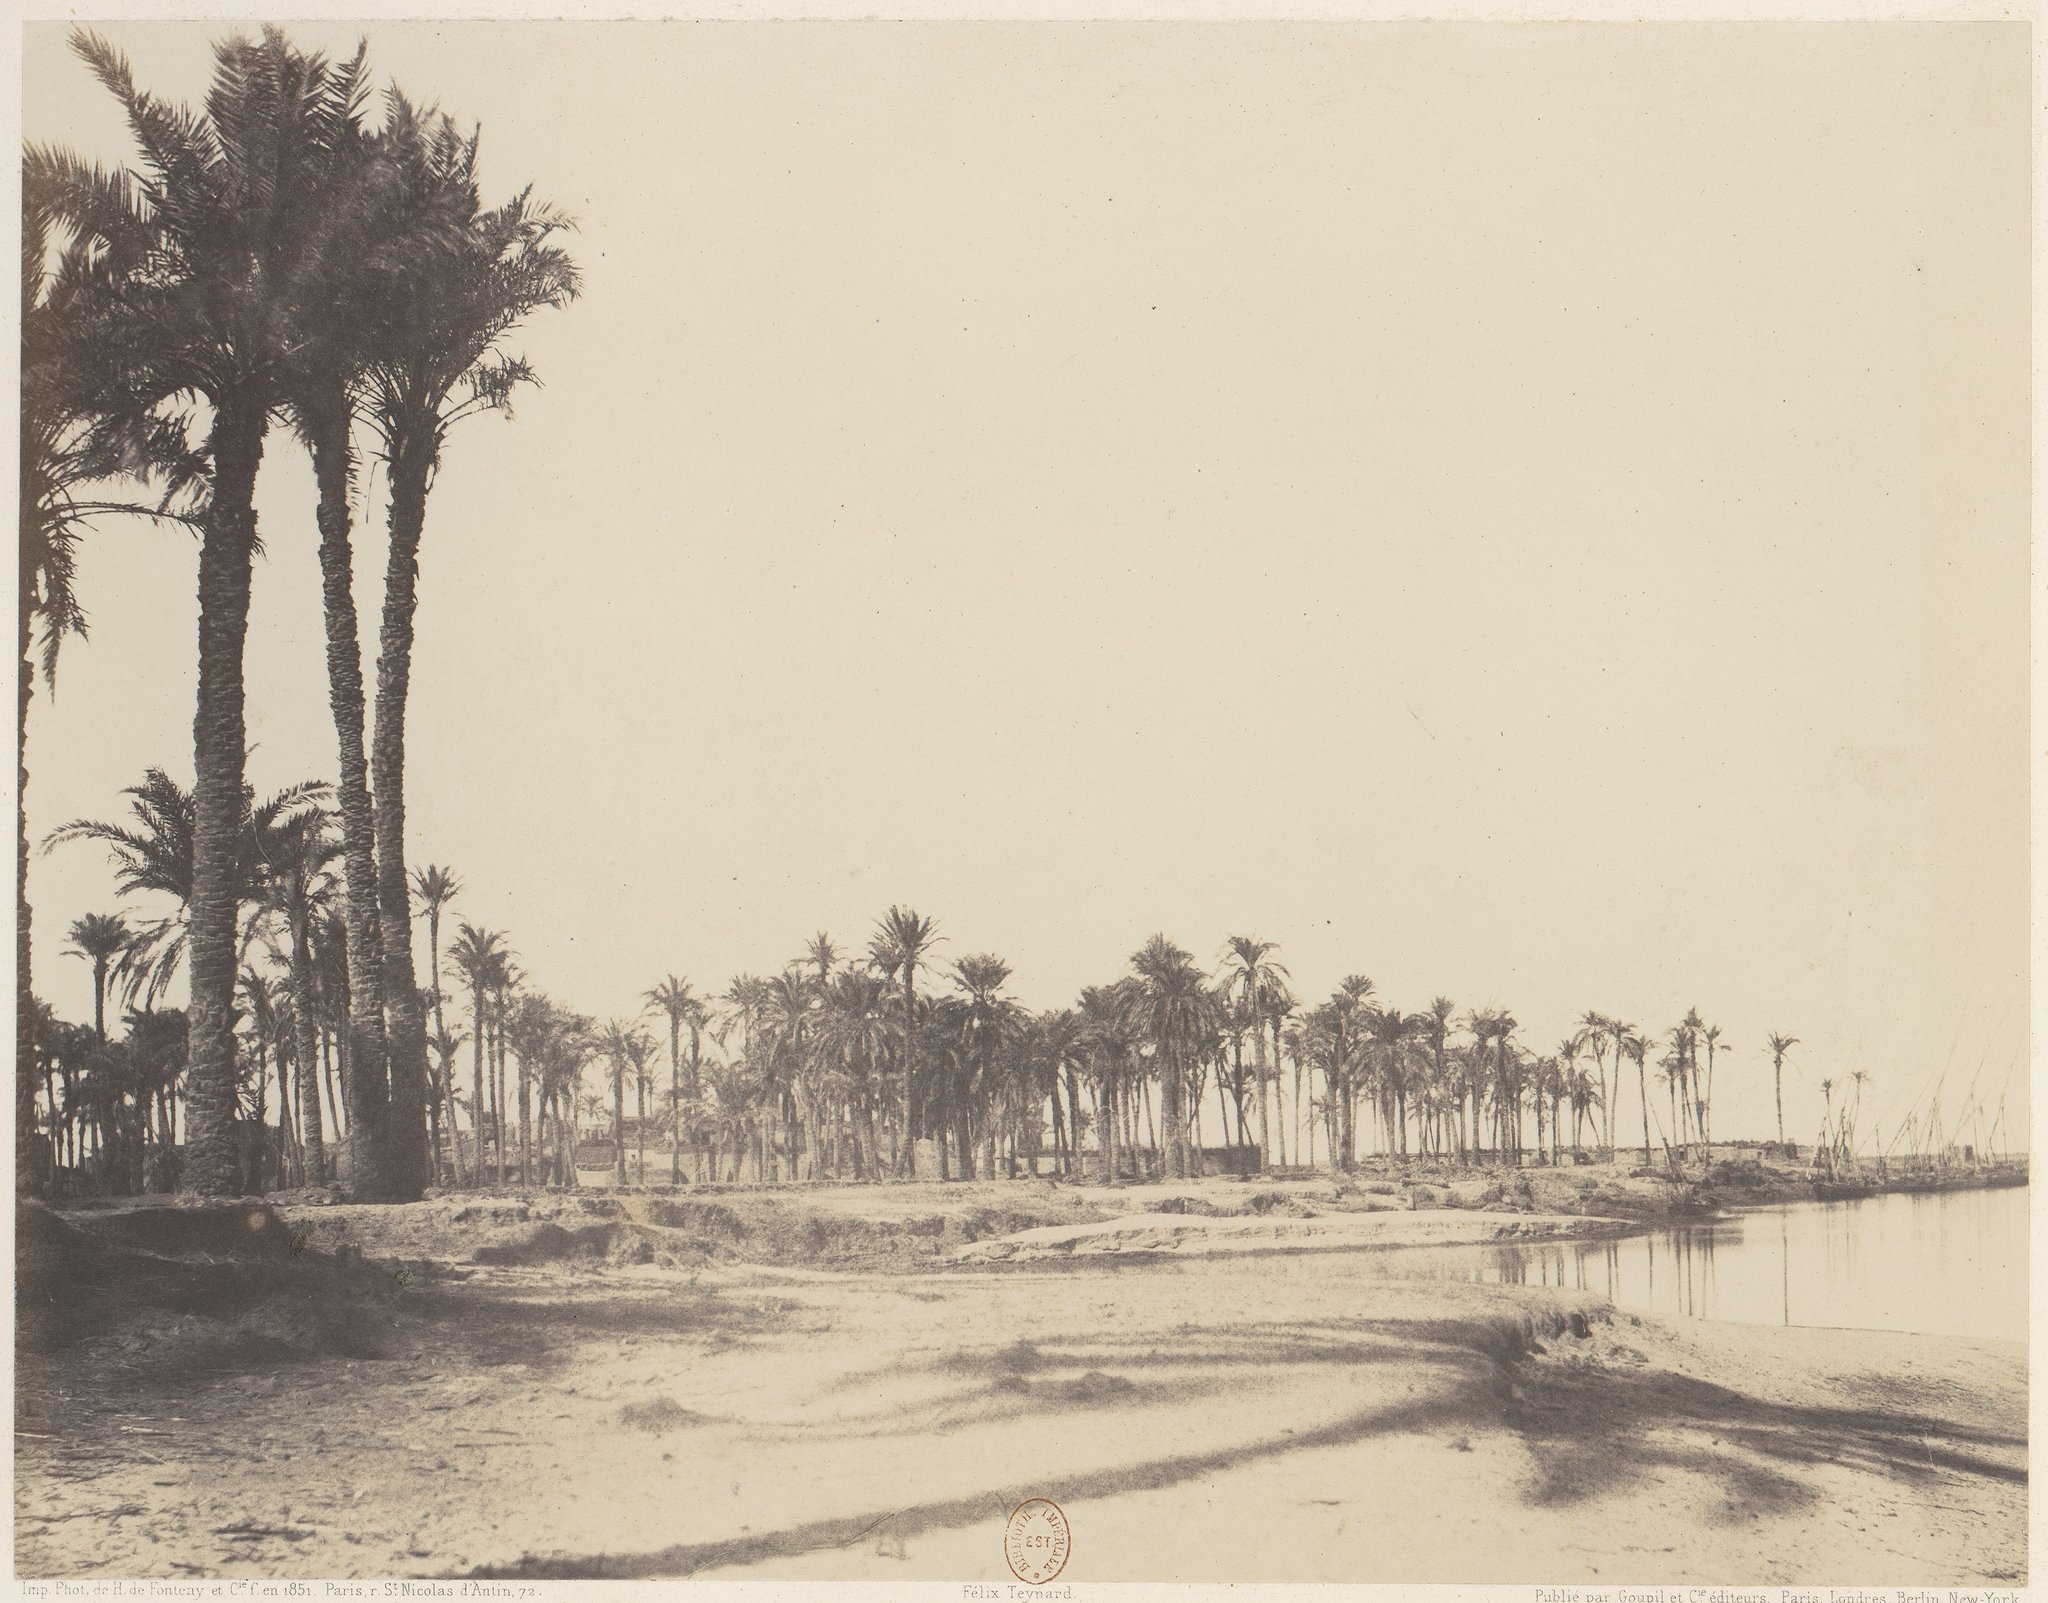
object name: photograph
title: El-Nâcérah, Dattiers, Rives du Nil et Barques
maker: félix teynard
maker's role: artist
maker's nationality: french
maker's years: 1817-1892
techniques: paper negative, salted paper print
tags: rivers,landscapes